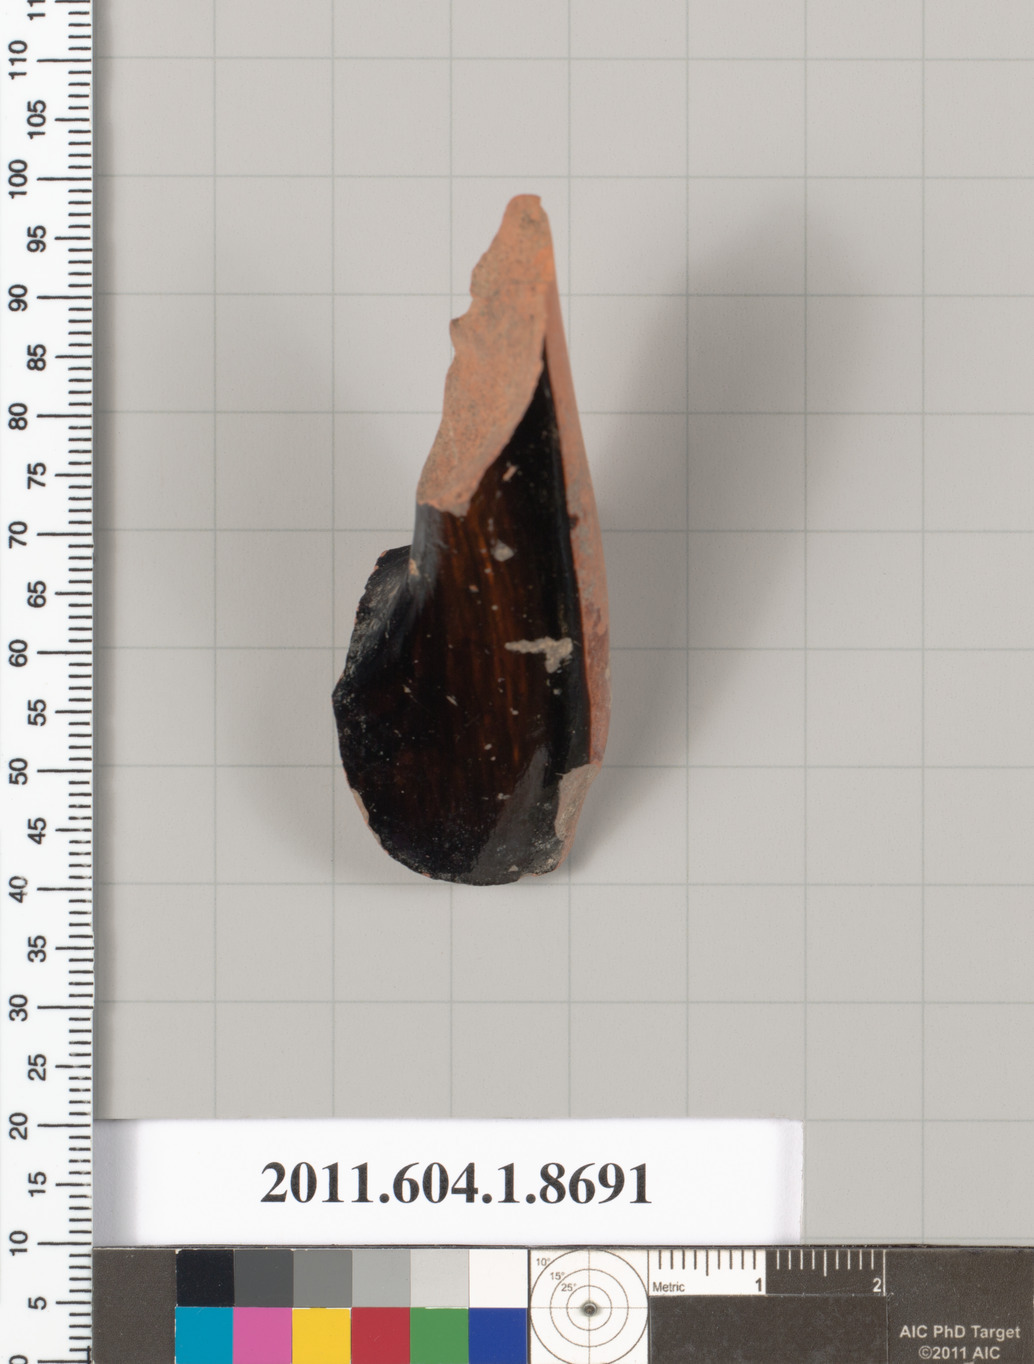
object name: kylix fragment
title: Terracotta fragment of a stemless kylix (drinking cup)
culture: greek, attic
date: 470-450 BCE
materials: terracotta